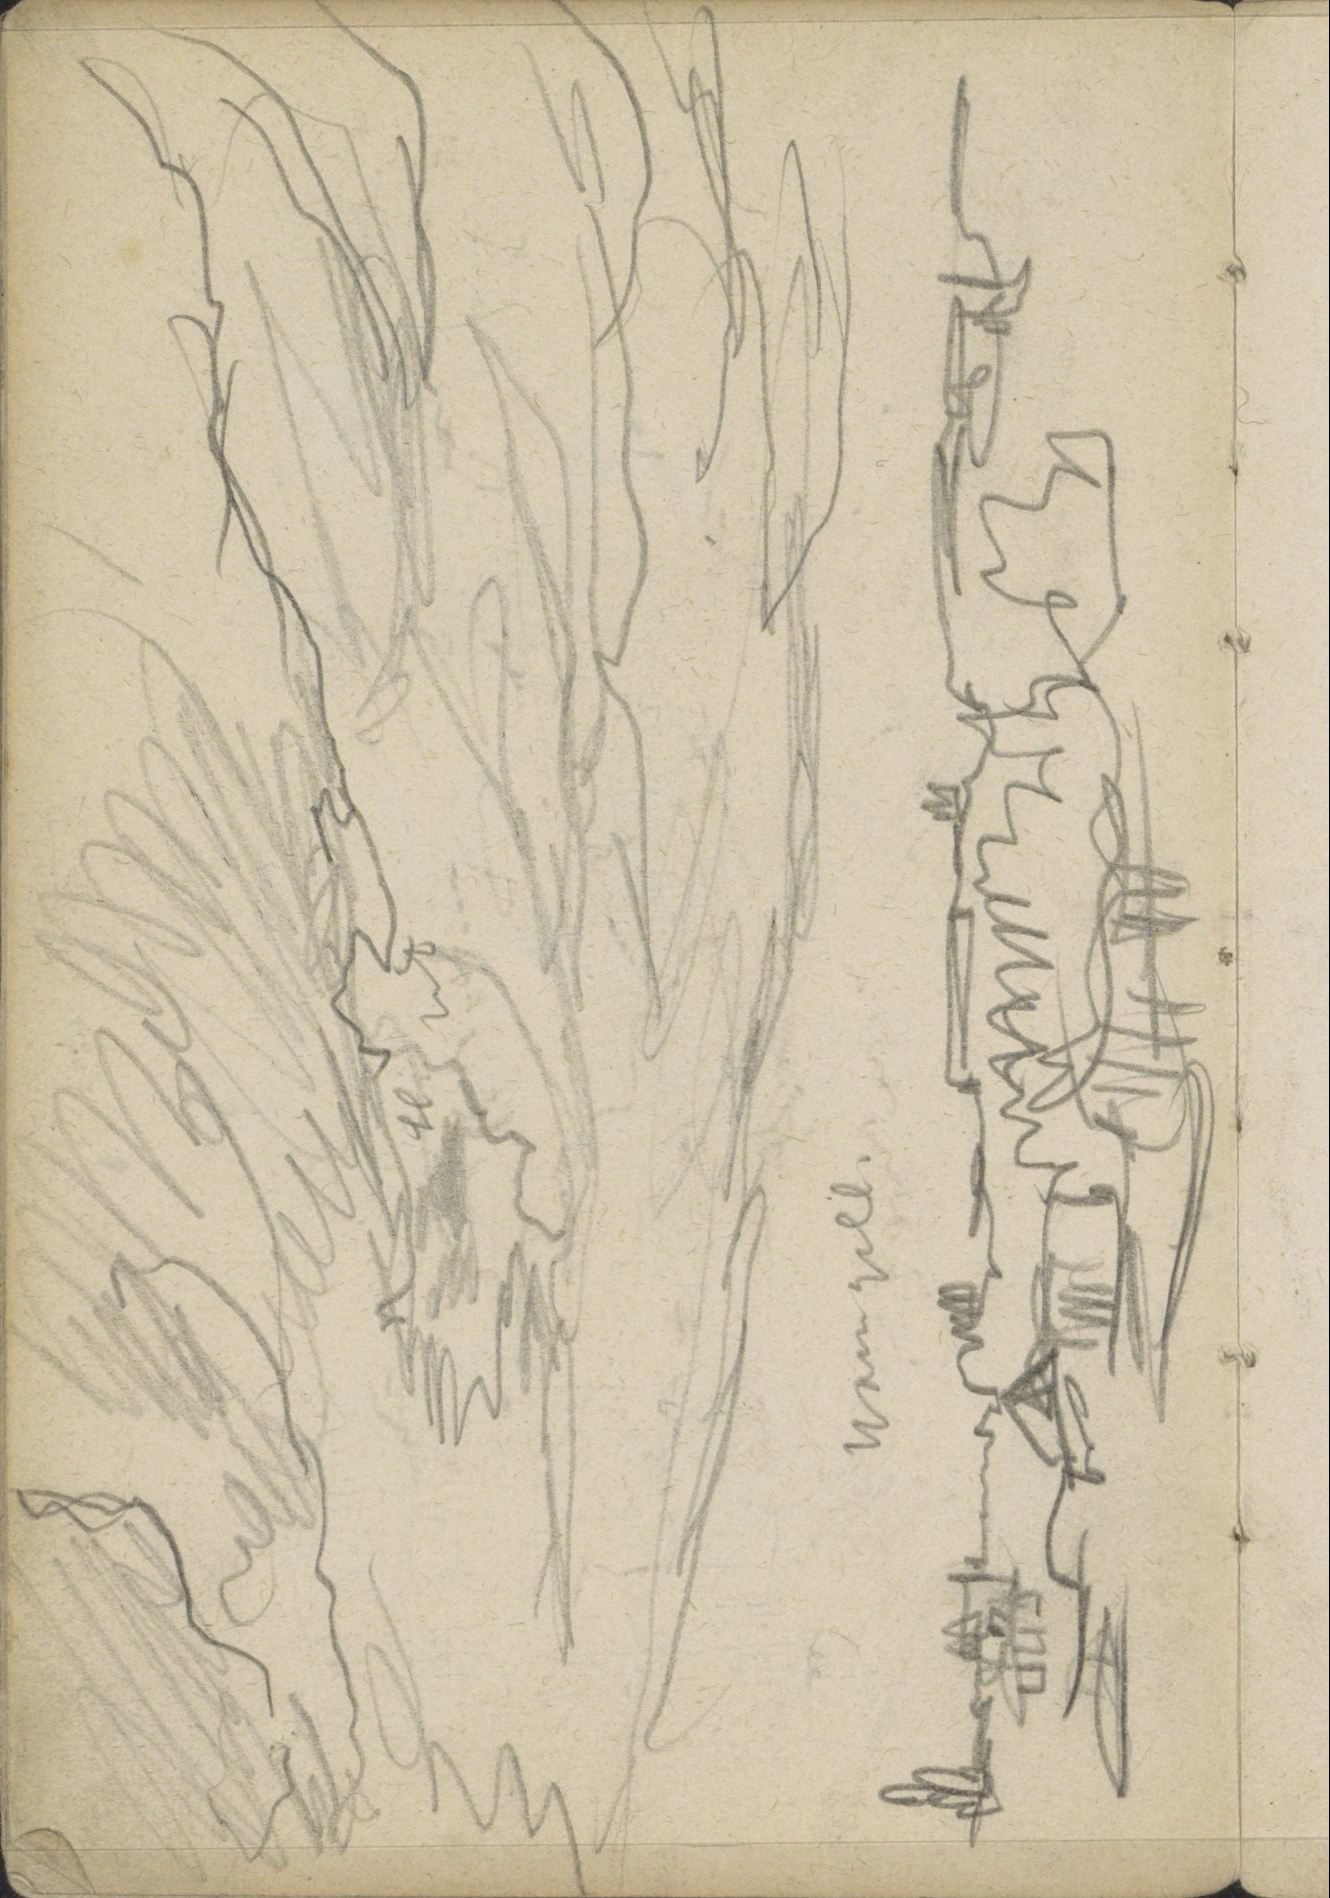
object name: sketchbook leaf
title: Landschap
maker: george hendrik breitner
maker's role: draughtsman, painter, print maker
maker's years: 1857-1923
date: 1900-1901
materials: paper, pencil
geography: north holland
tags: landscapes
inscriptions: kleurnotitie, handgeschreven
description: Landschap. Pagina 9 uit een schetsboek met 46 bladen vervaardigd te Amsterdam.